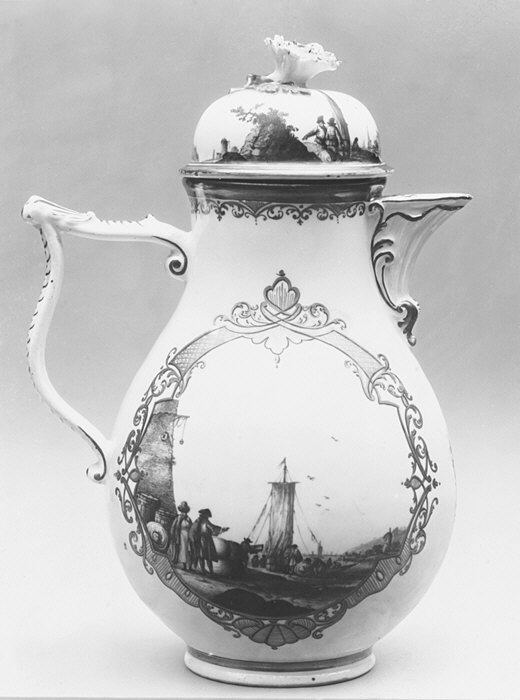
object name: coffee or chocolate pot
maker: meissen manufactory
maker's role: manufactory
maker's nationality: german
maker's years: 1710-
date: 1740-1745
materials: hard paste porcelain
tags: human figures,boats